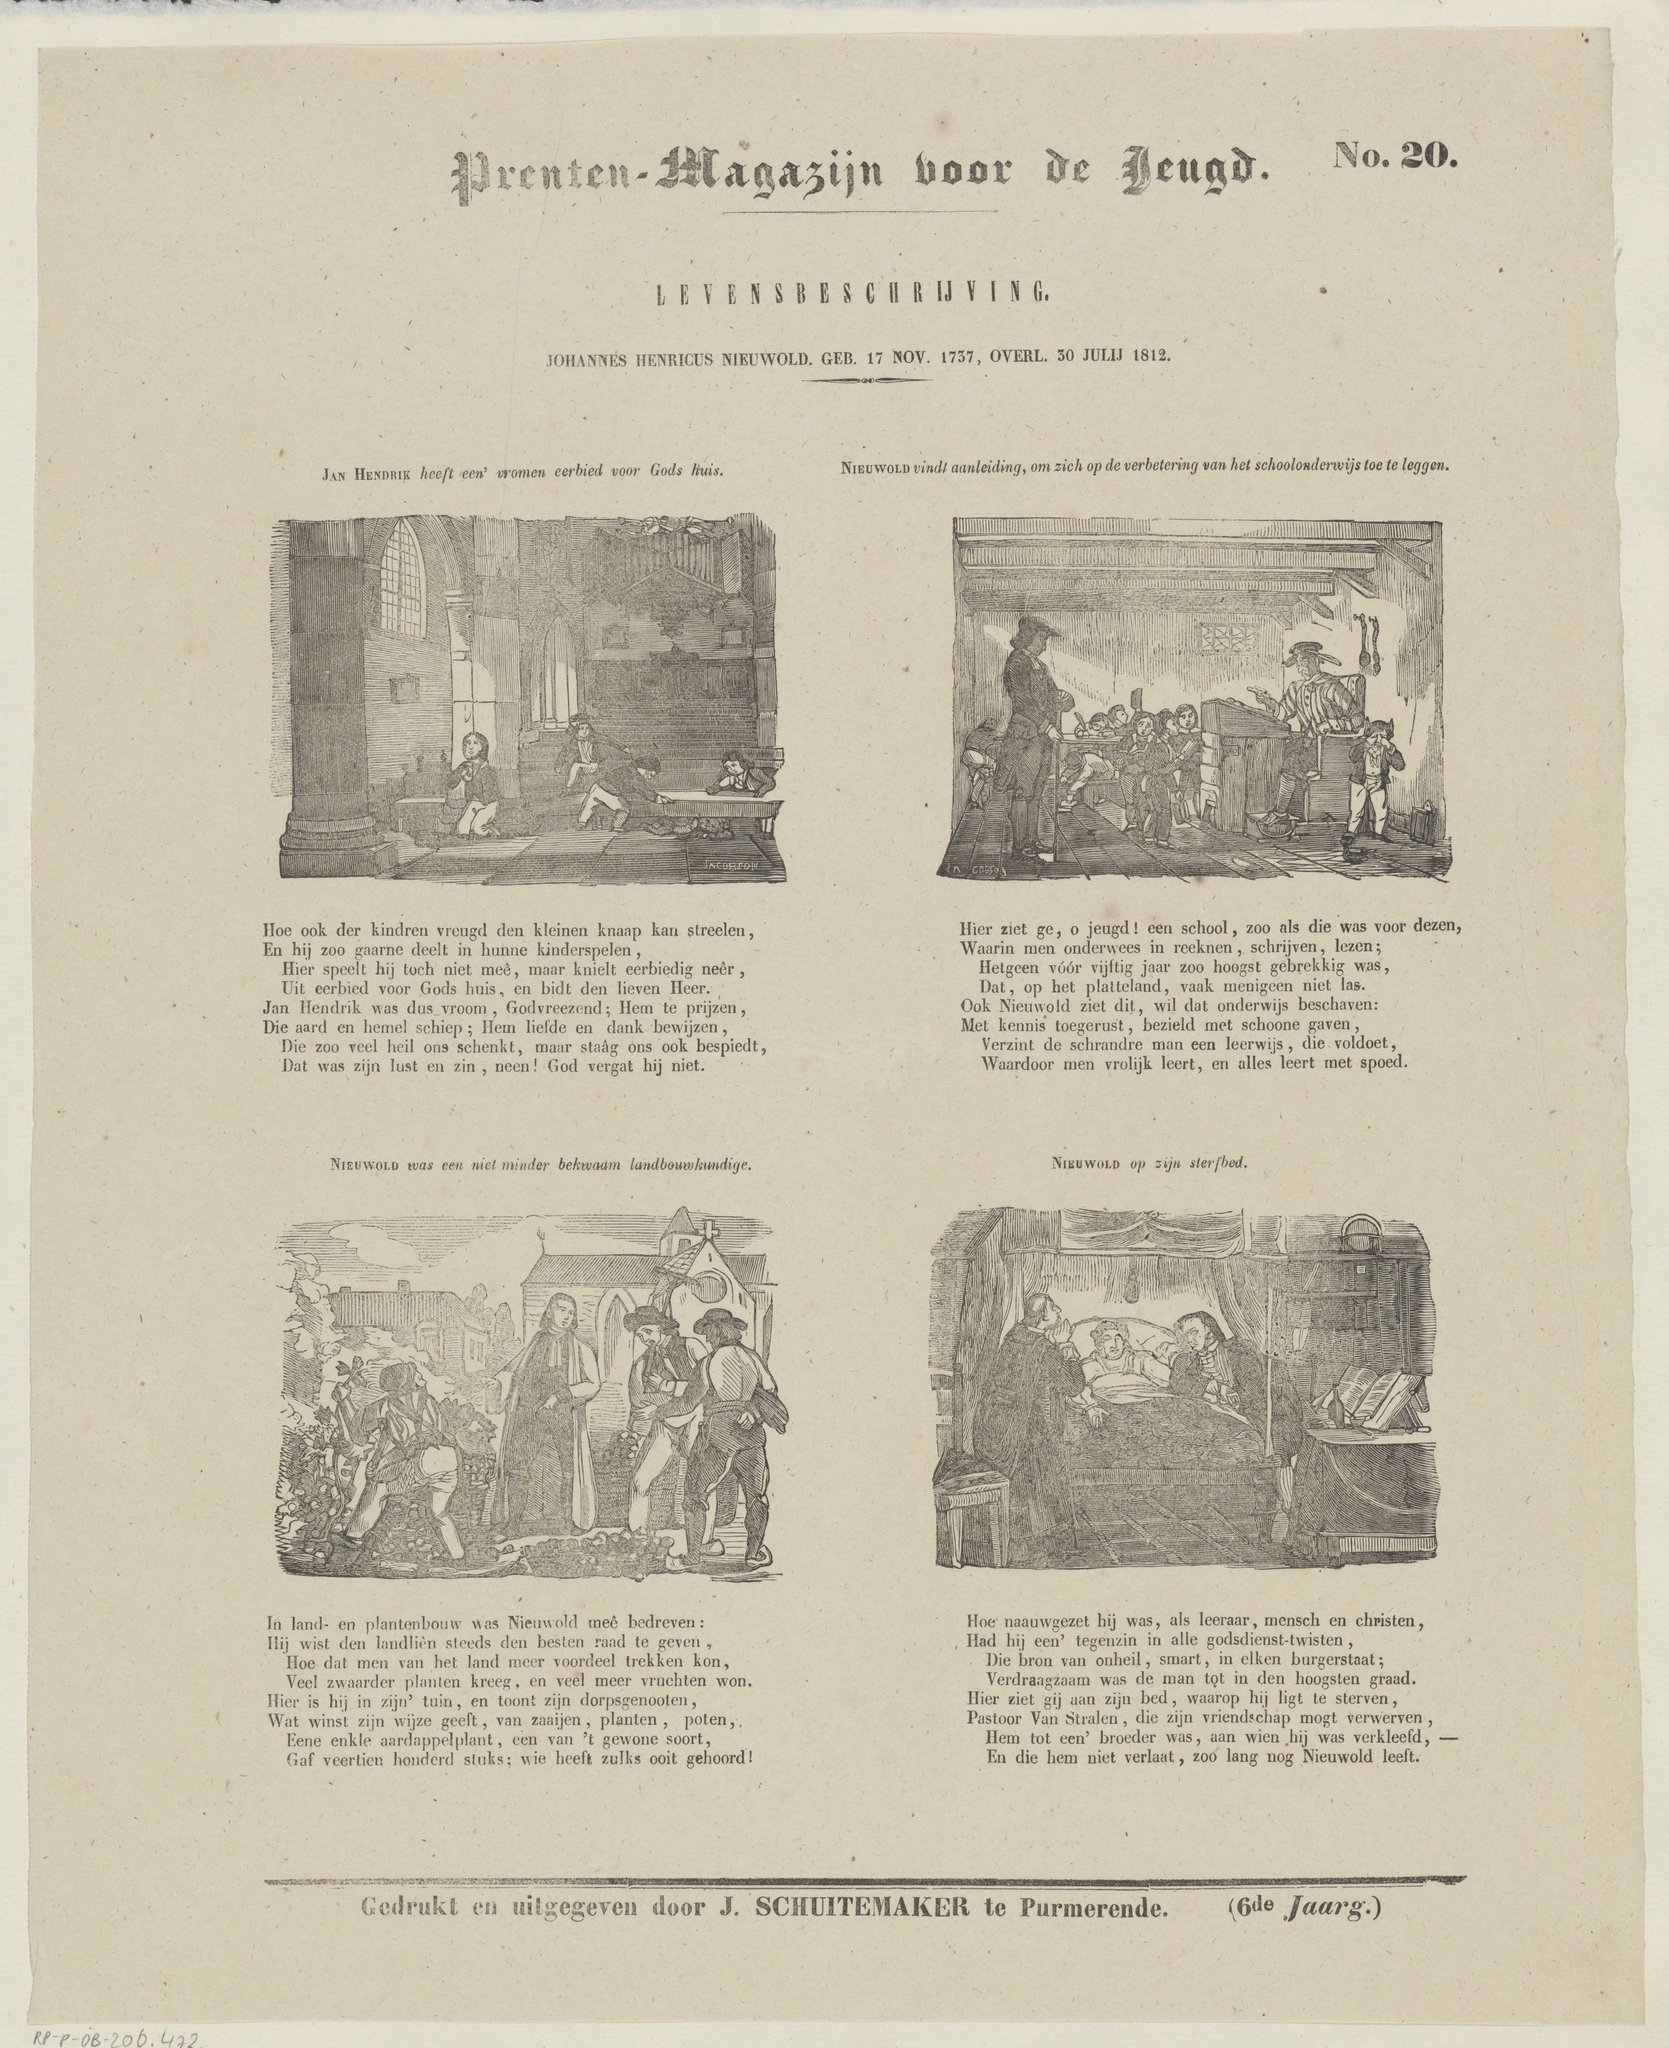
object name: popular print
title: Prenten-magazijn voor de jeugd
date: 1847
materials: paper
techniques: letterpress printing, engraving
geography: purmerend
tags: historical persons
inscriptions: collector's mark: Lugt 2760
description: Blad met 4 voorstellingen uit het leven van Johannes Henricus Nieuwold. Boven elke afbeelding een titel, onder elke afbeelding een achtregelig vers. Genummerd rechtsboven: No. 20.